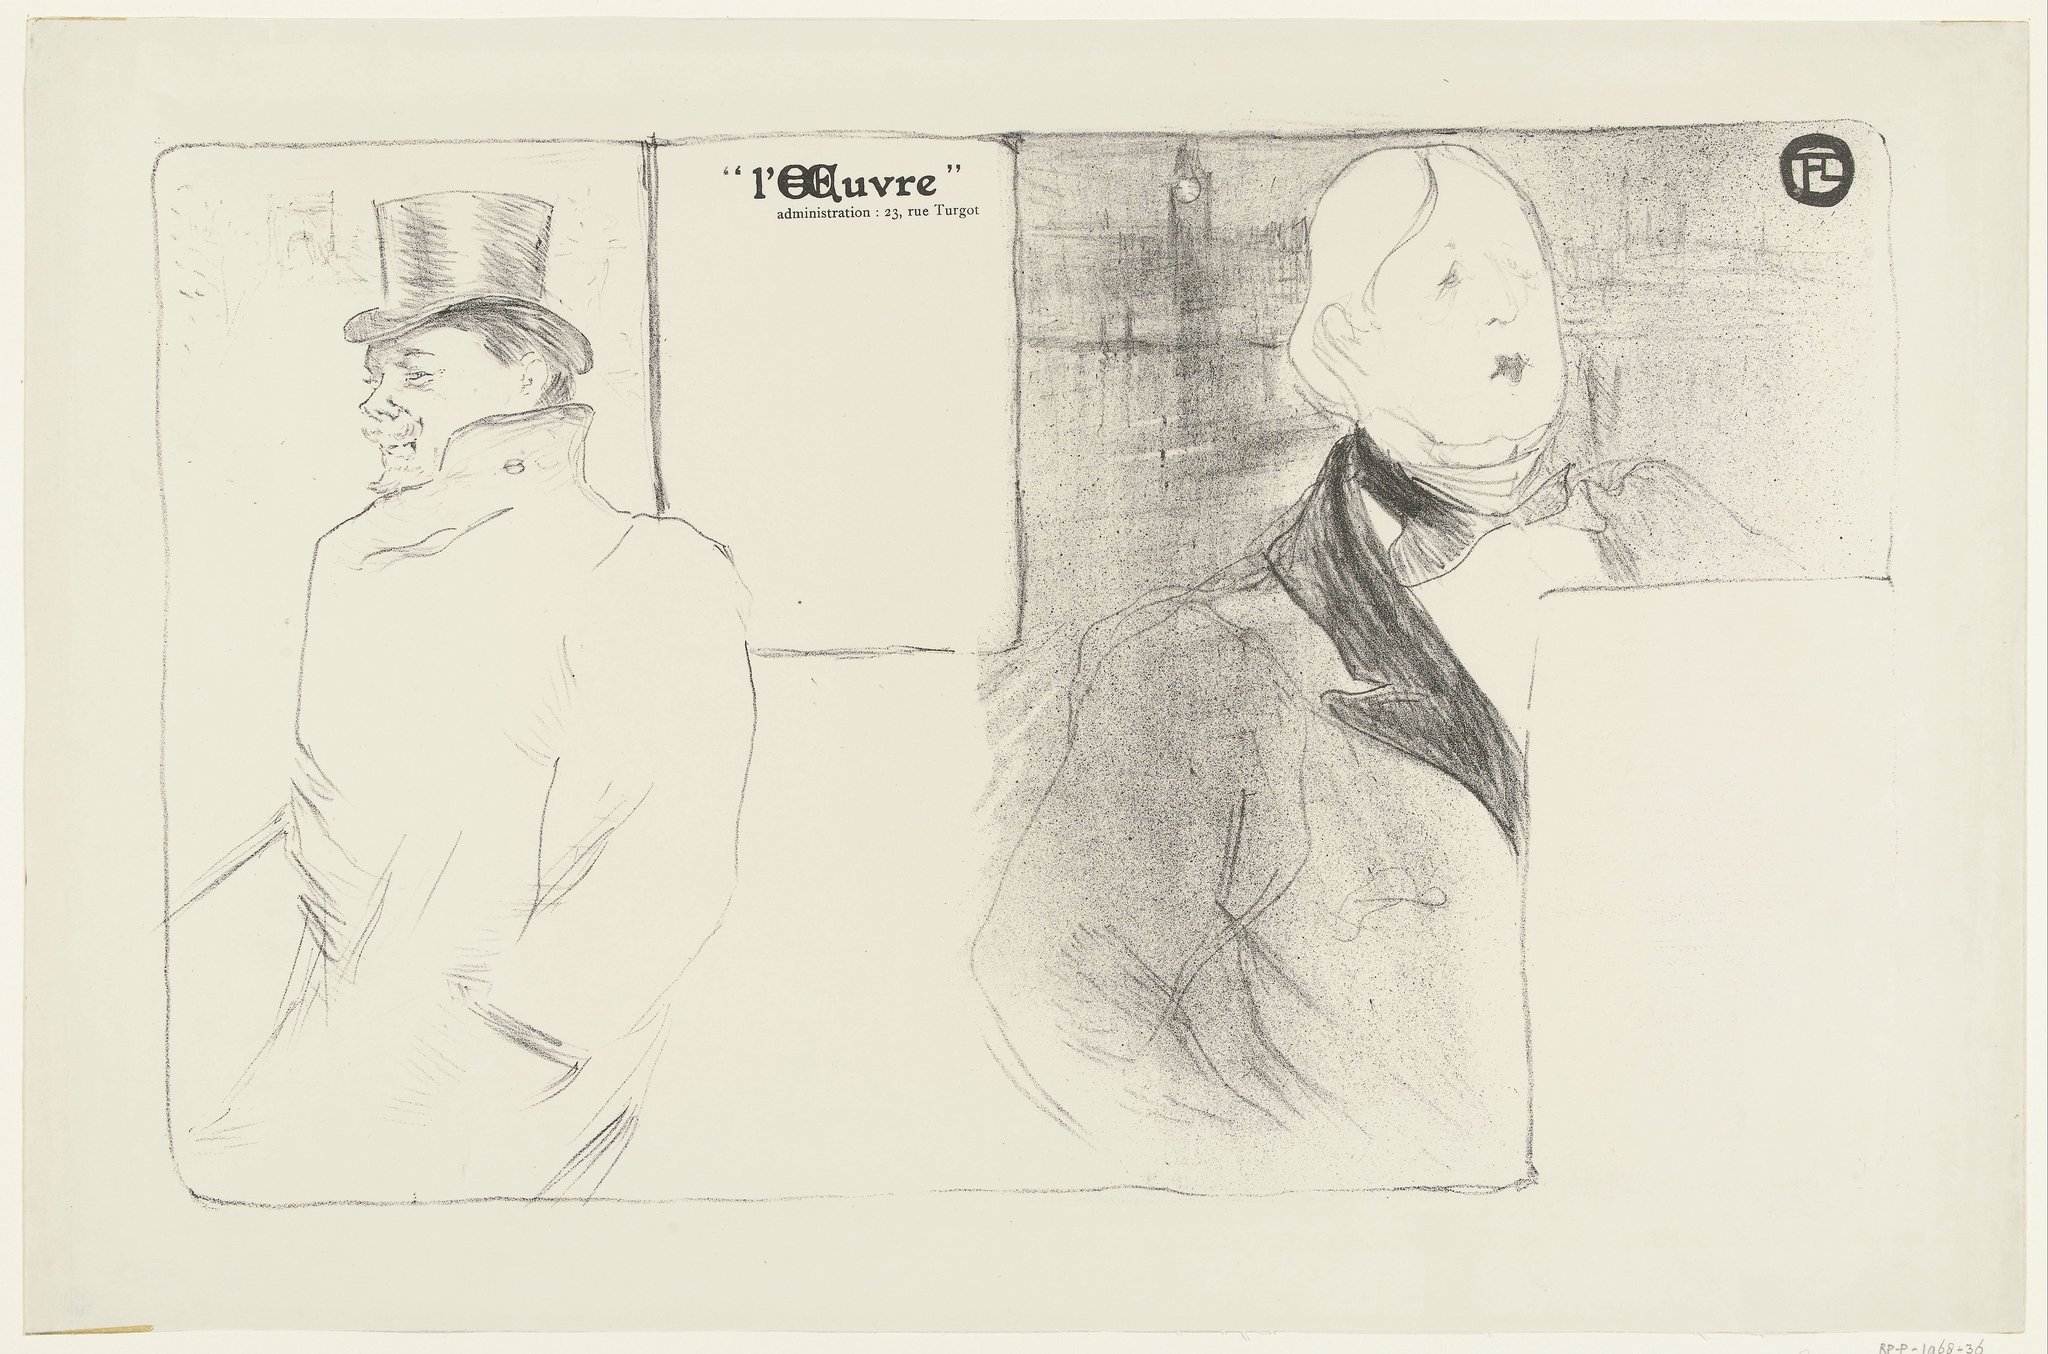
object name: print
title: Ontwerp voor programma bij theater L'Oeuvre met portret van schrijvers Oscar Wilde en Romain Coolus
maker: henri de toulouse-lautrec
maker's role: draughtsman, painter, print maker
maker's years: 1864-1901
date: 1896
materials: paper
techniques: lithograph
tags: paris, portrait of a writer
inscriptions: collector's mark: Lugt 2228, collector's mark: Lugt, collector's mark: Lugt 2760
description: Ontwerp voor programma bij theater L'Oeuvre met portret van schrijvers Oscar Wilde (rechts) en Romain Coolus (links). Het programma werd gebruikt voor een aankondiging van twee toneelstukken, Raphaël van Coolus en Salomé van Wilde.